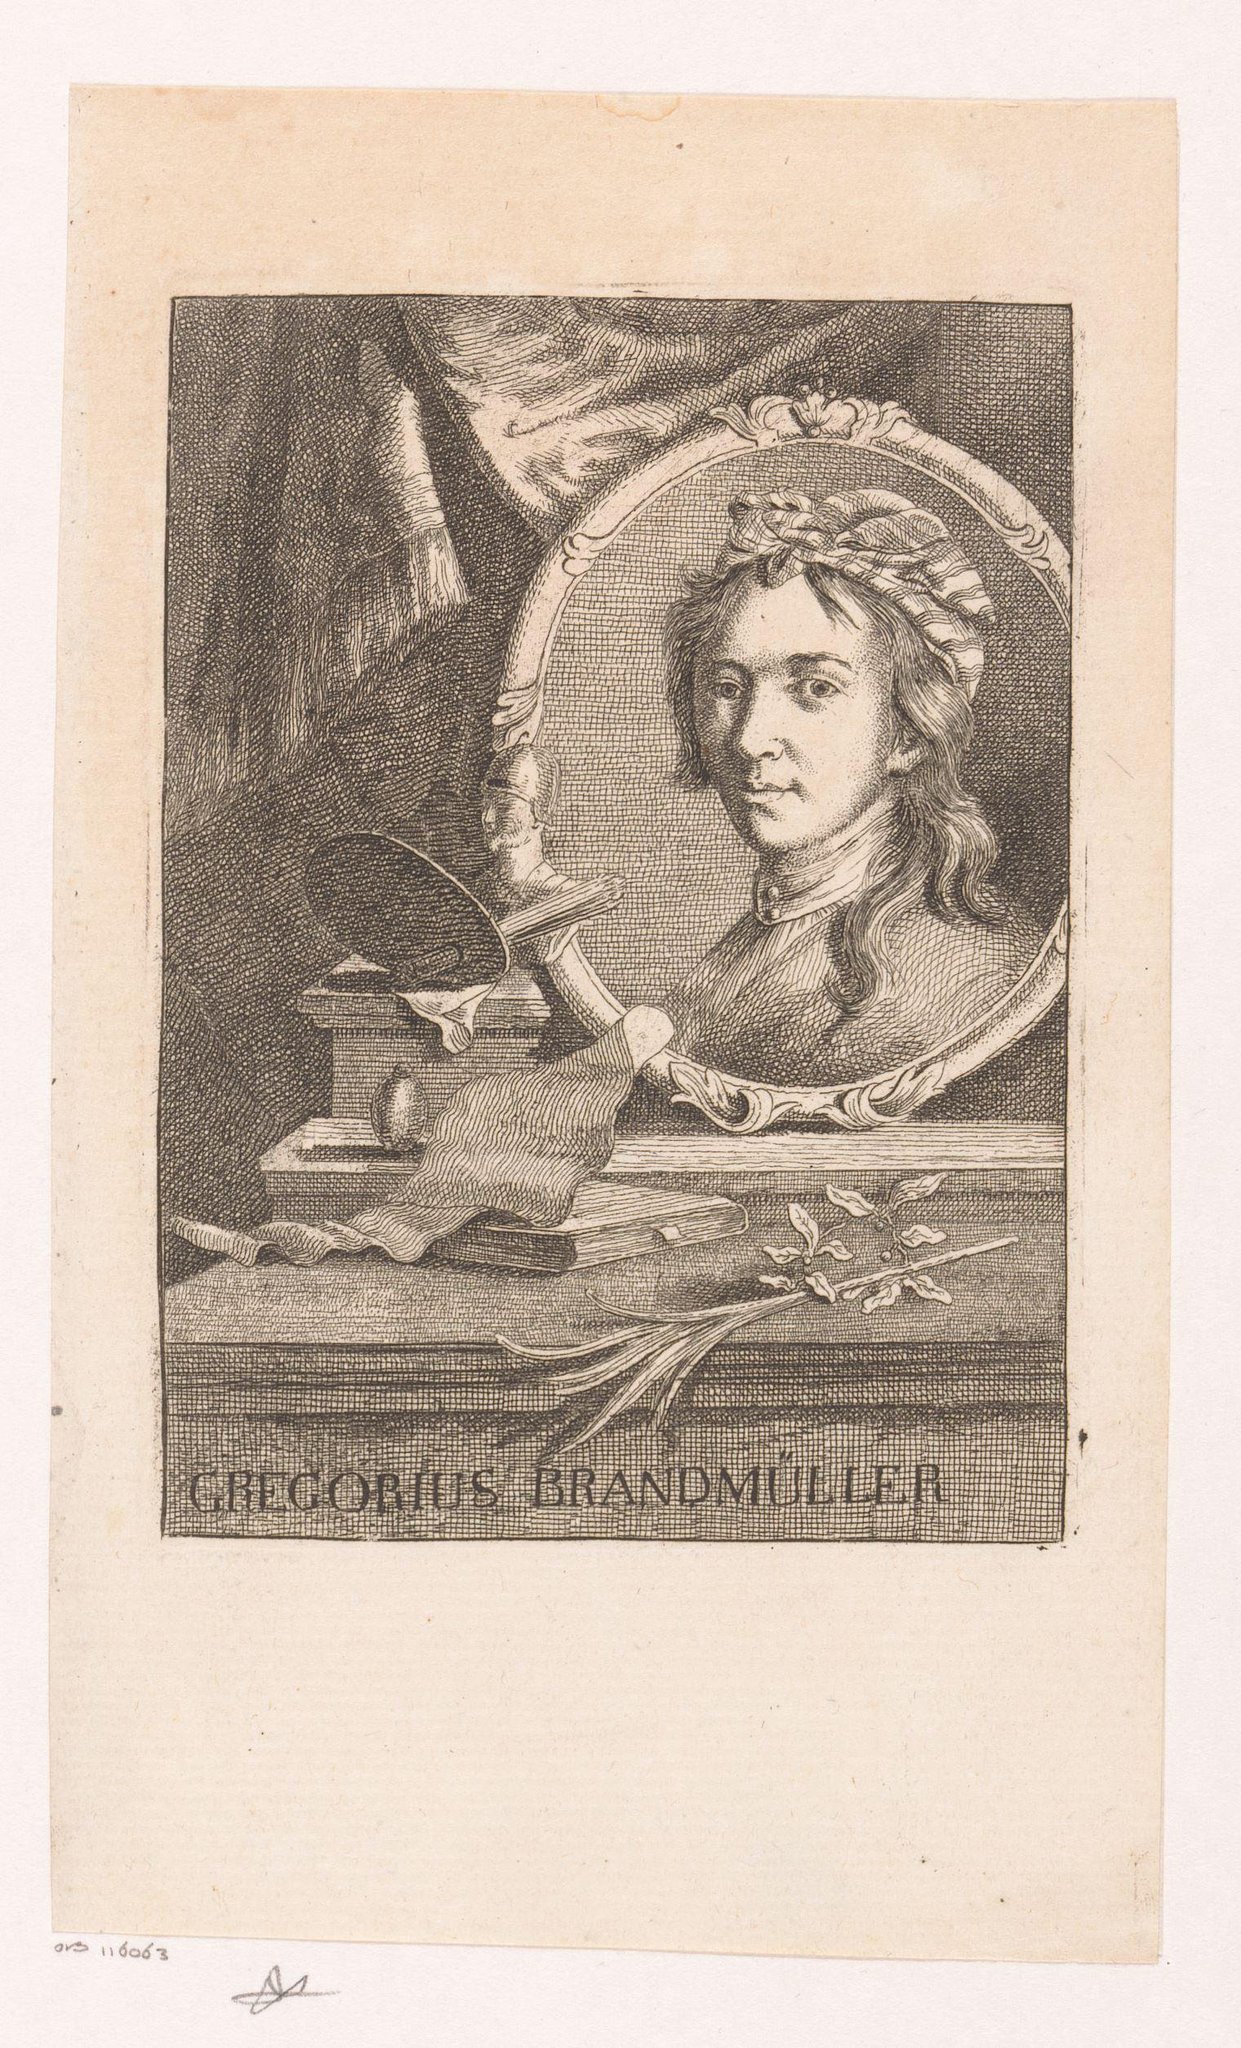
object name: print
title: Portret van Gregorius Brandmüller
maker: rudolf füssli (der jüngste)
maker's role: print maker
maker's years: 1737-1806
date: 1755-1757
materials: paper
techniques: etching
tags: painter, trees: palm-tree (+ branch, stick), ornament ~ medallion, historical persons, tools, implements of painter, book, trees: olive-tree (+ branch, stick)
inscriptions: collector's mark: Lugt 2228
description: Prent gebruikt voor: Füssli, Johann Kaspar. Geschichte Und Abbildung der besten Mahler in der Schweitz. Zürich: David Gessner, 1755-1757.